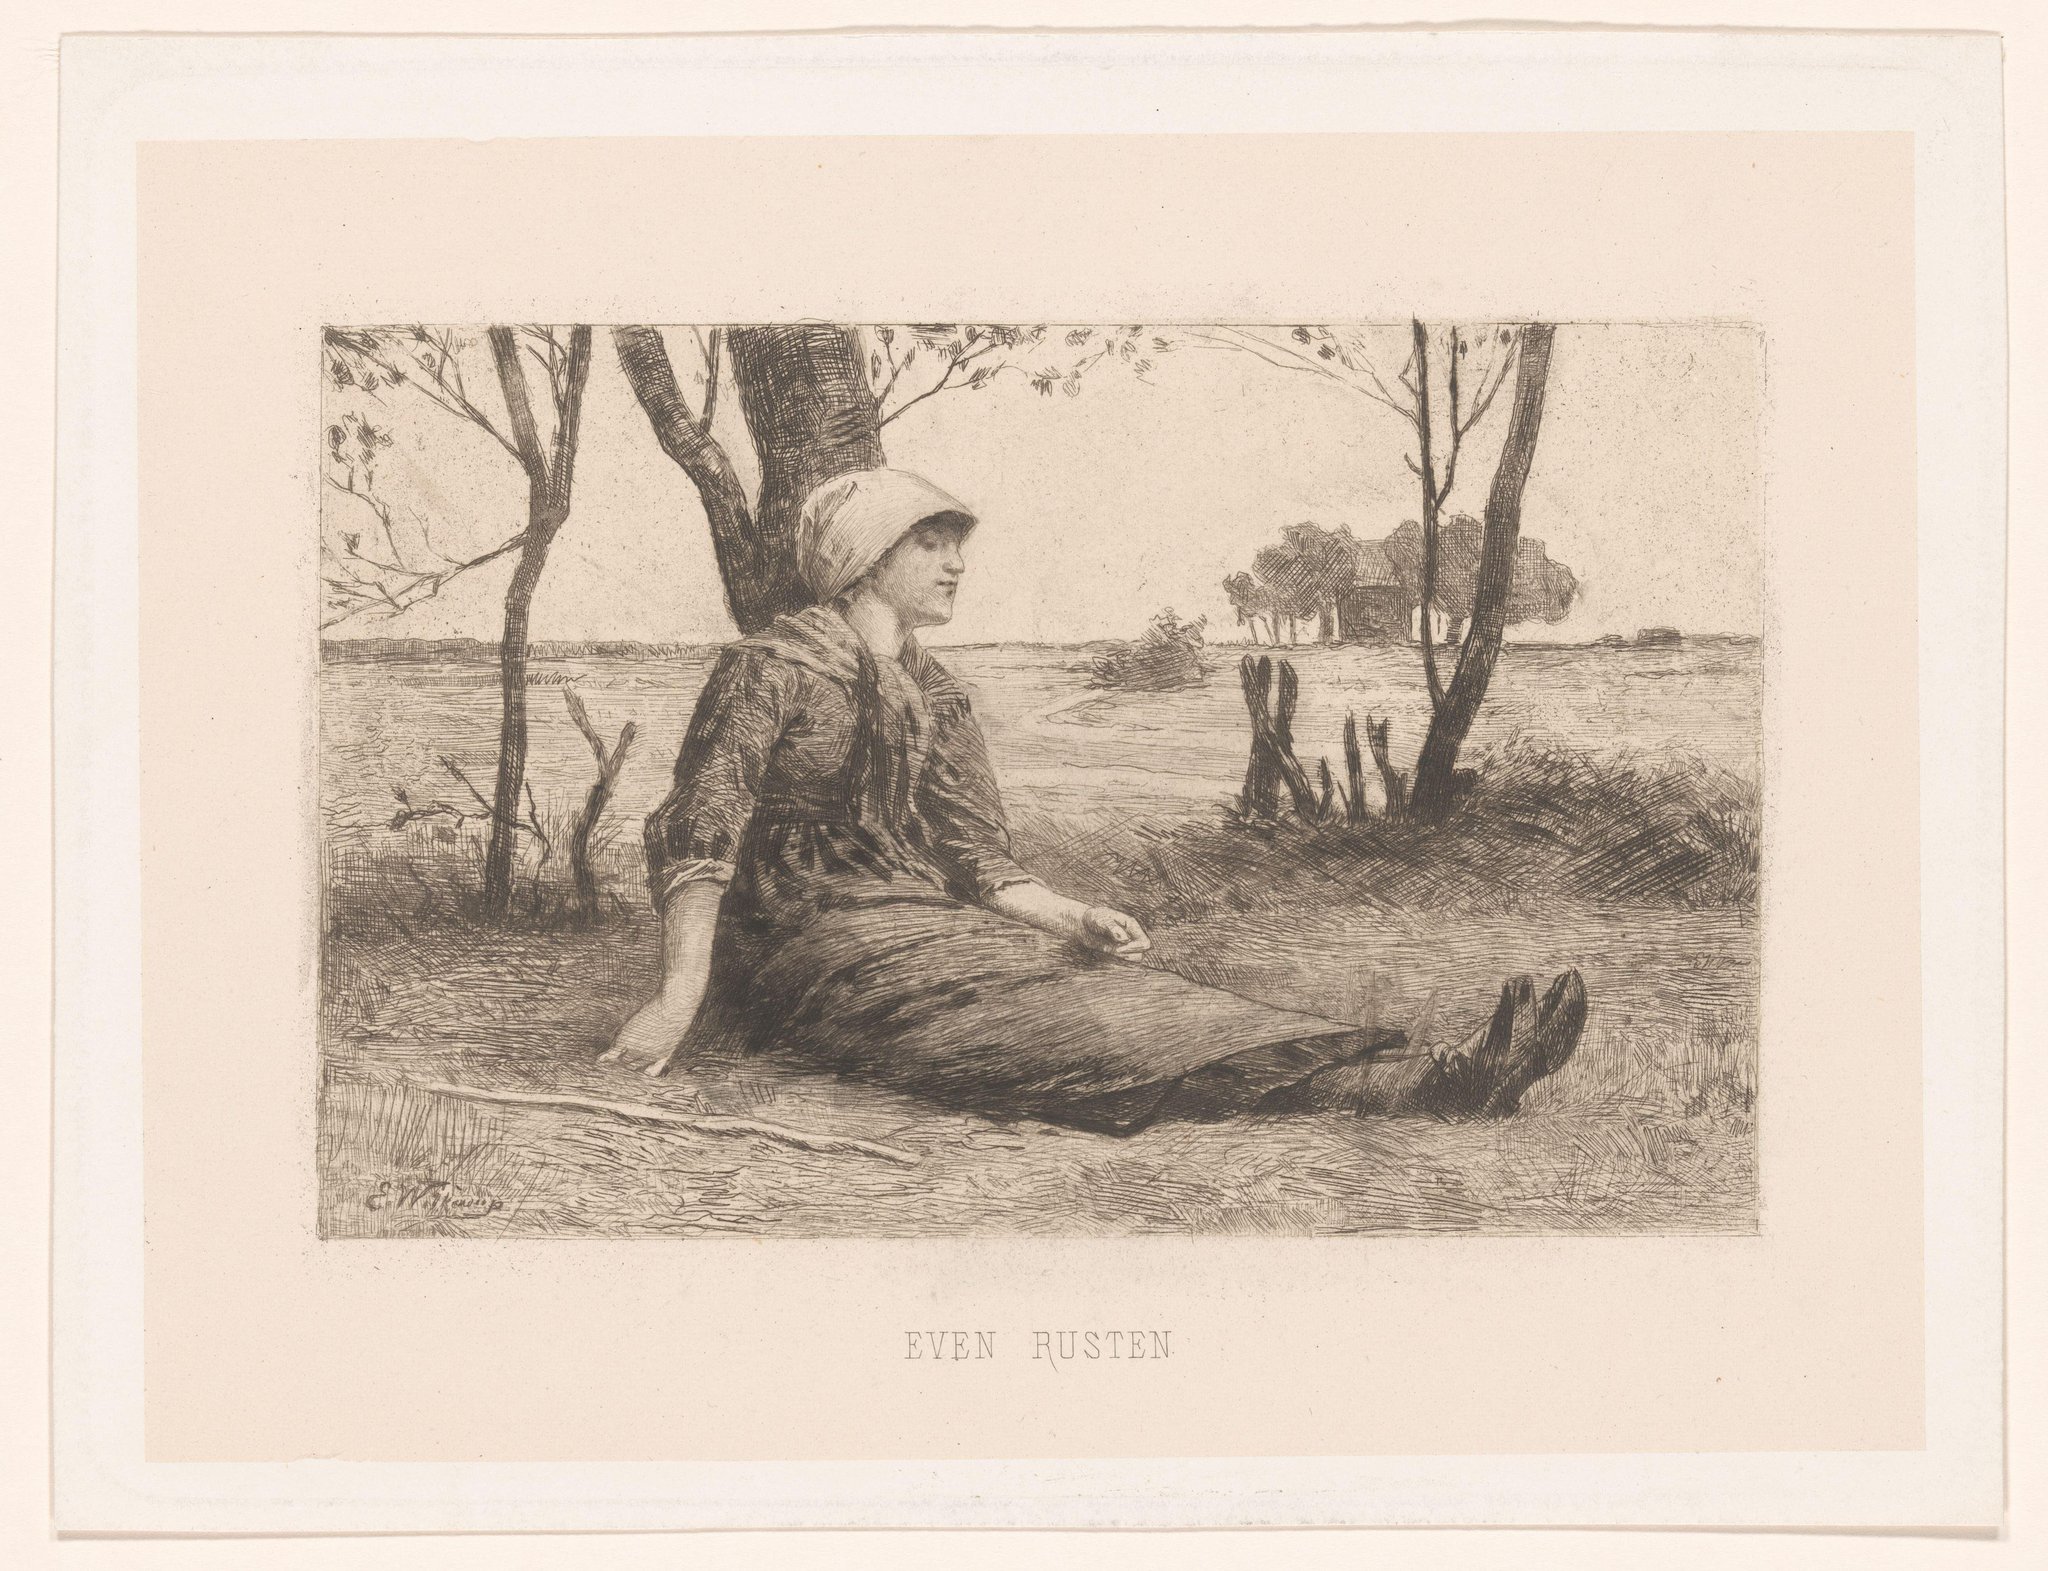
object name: print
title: Even rusten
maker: ernst witkamp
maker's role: draughtsman, print maker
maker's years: 1854-1897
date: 1888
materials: paper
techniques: drypoint, etching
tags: trees, leaning backward - aa - female human figure, landscapes in the temperate zone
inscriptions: collector's mark: Lugt 2228, inscription: ‘distel 1888’